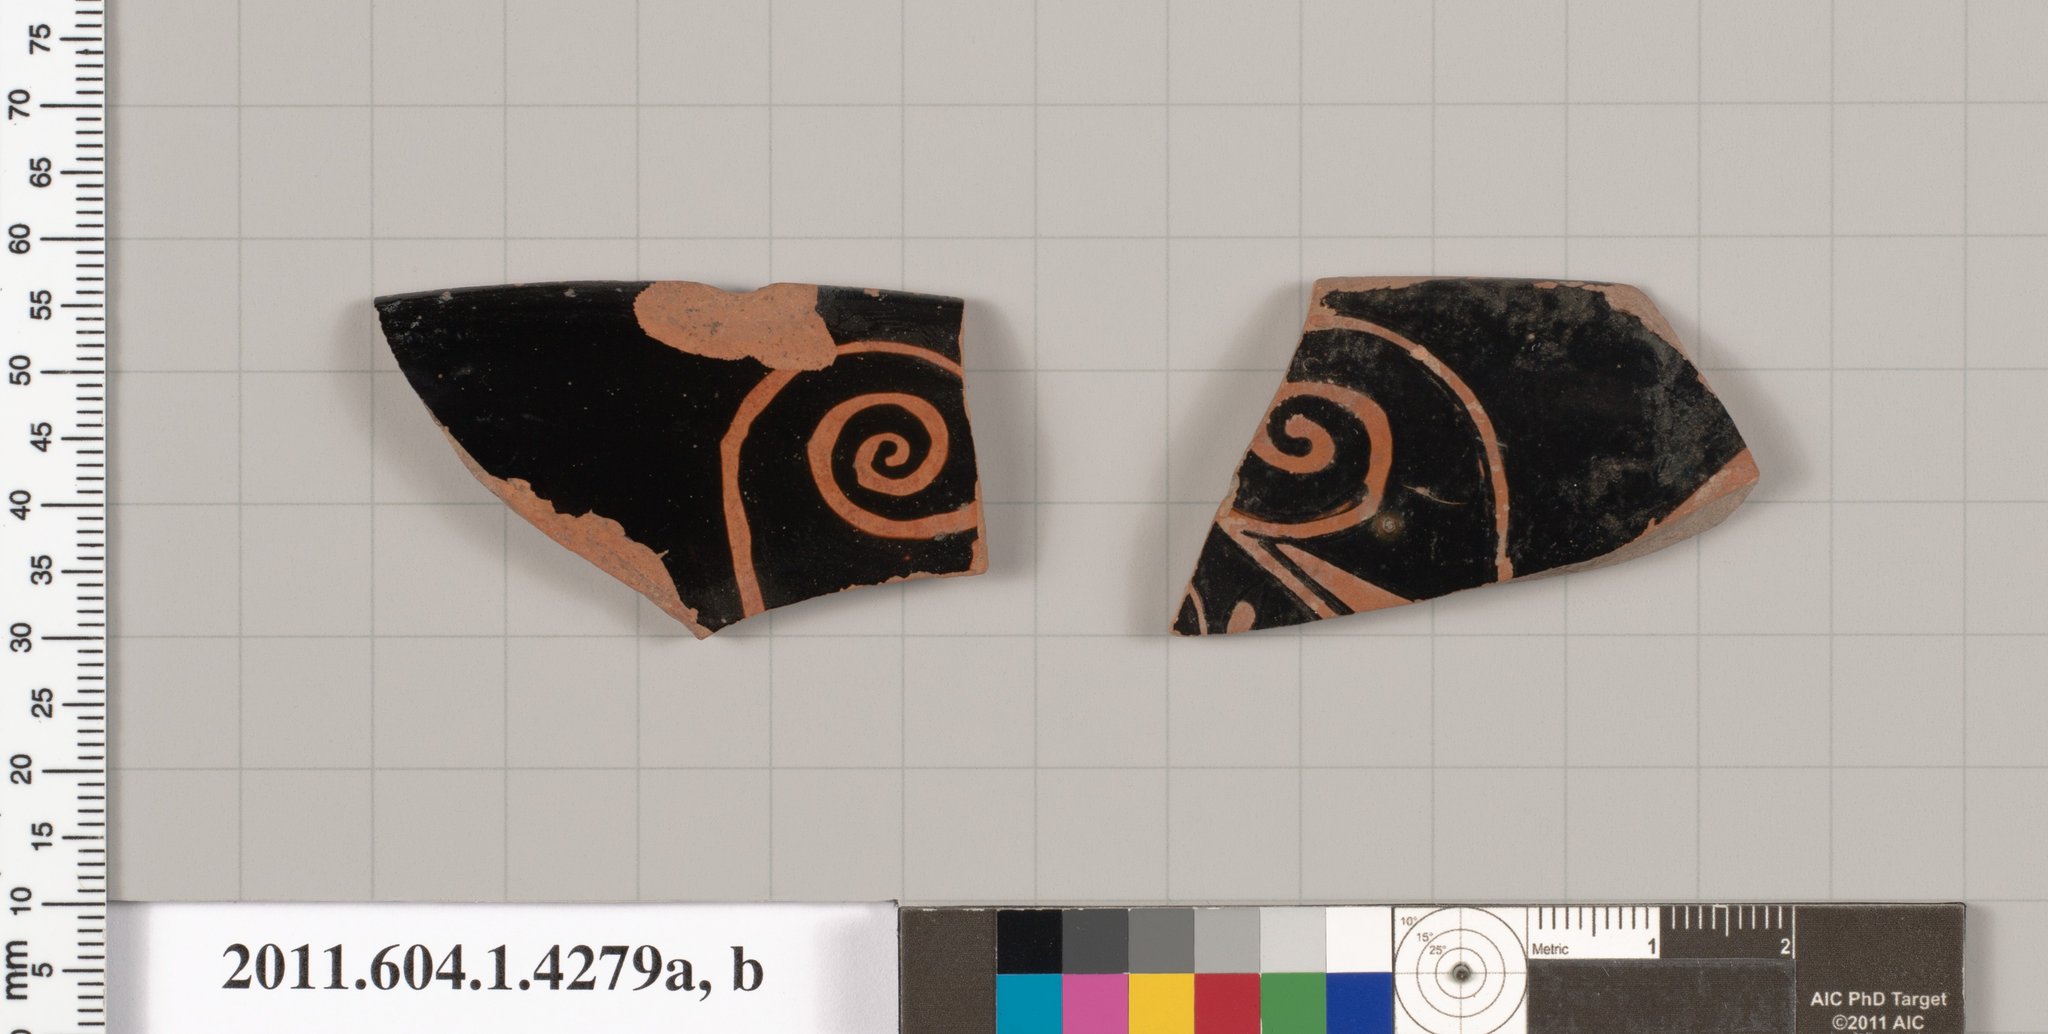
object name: kylix fragment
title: Terracotta rim fragments of kylikes (drinking cups)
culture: greek, attic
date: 500-451 BCE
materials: terracotta